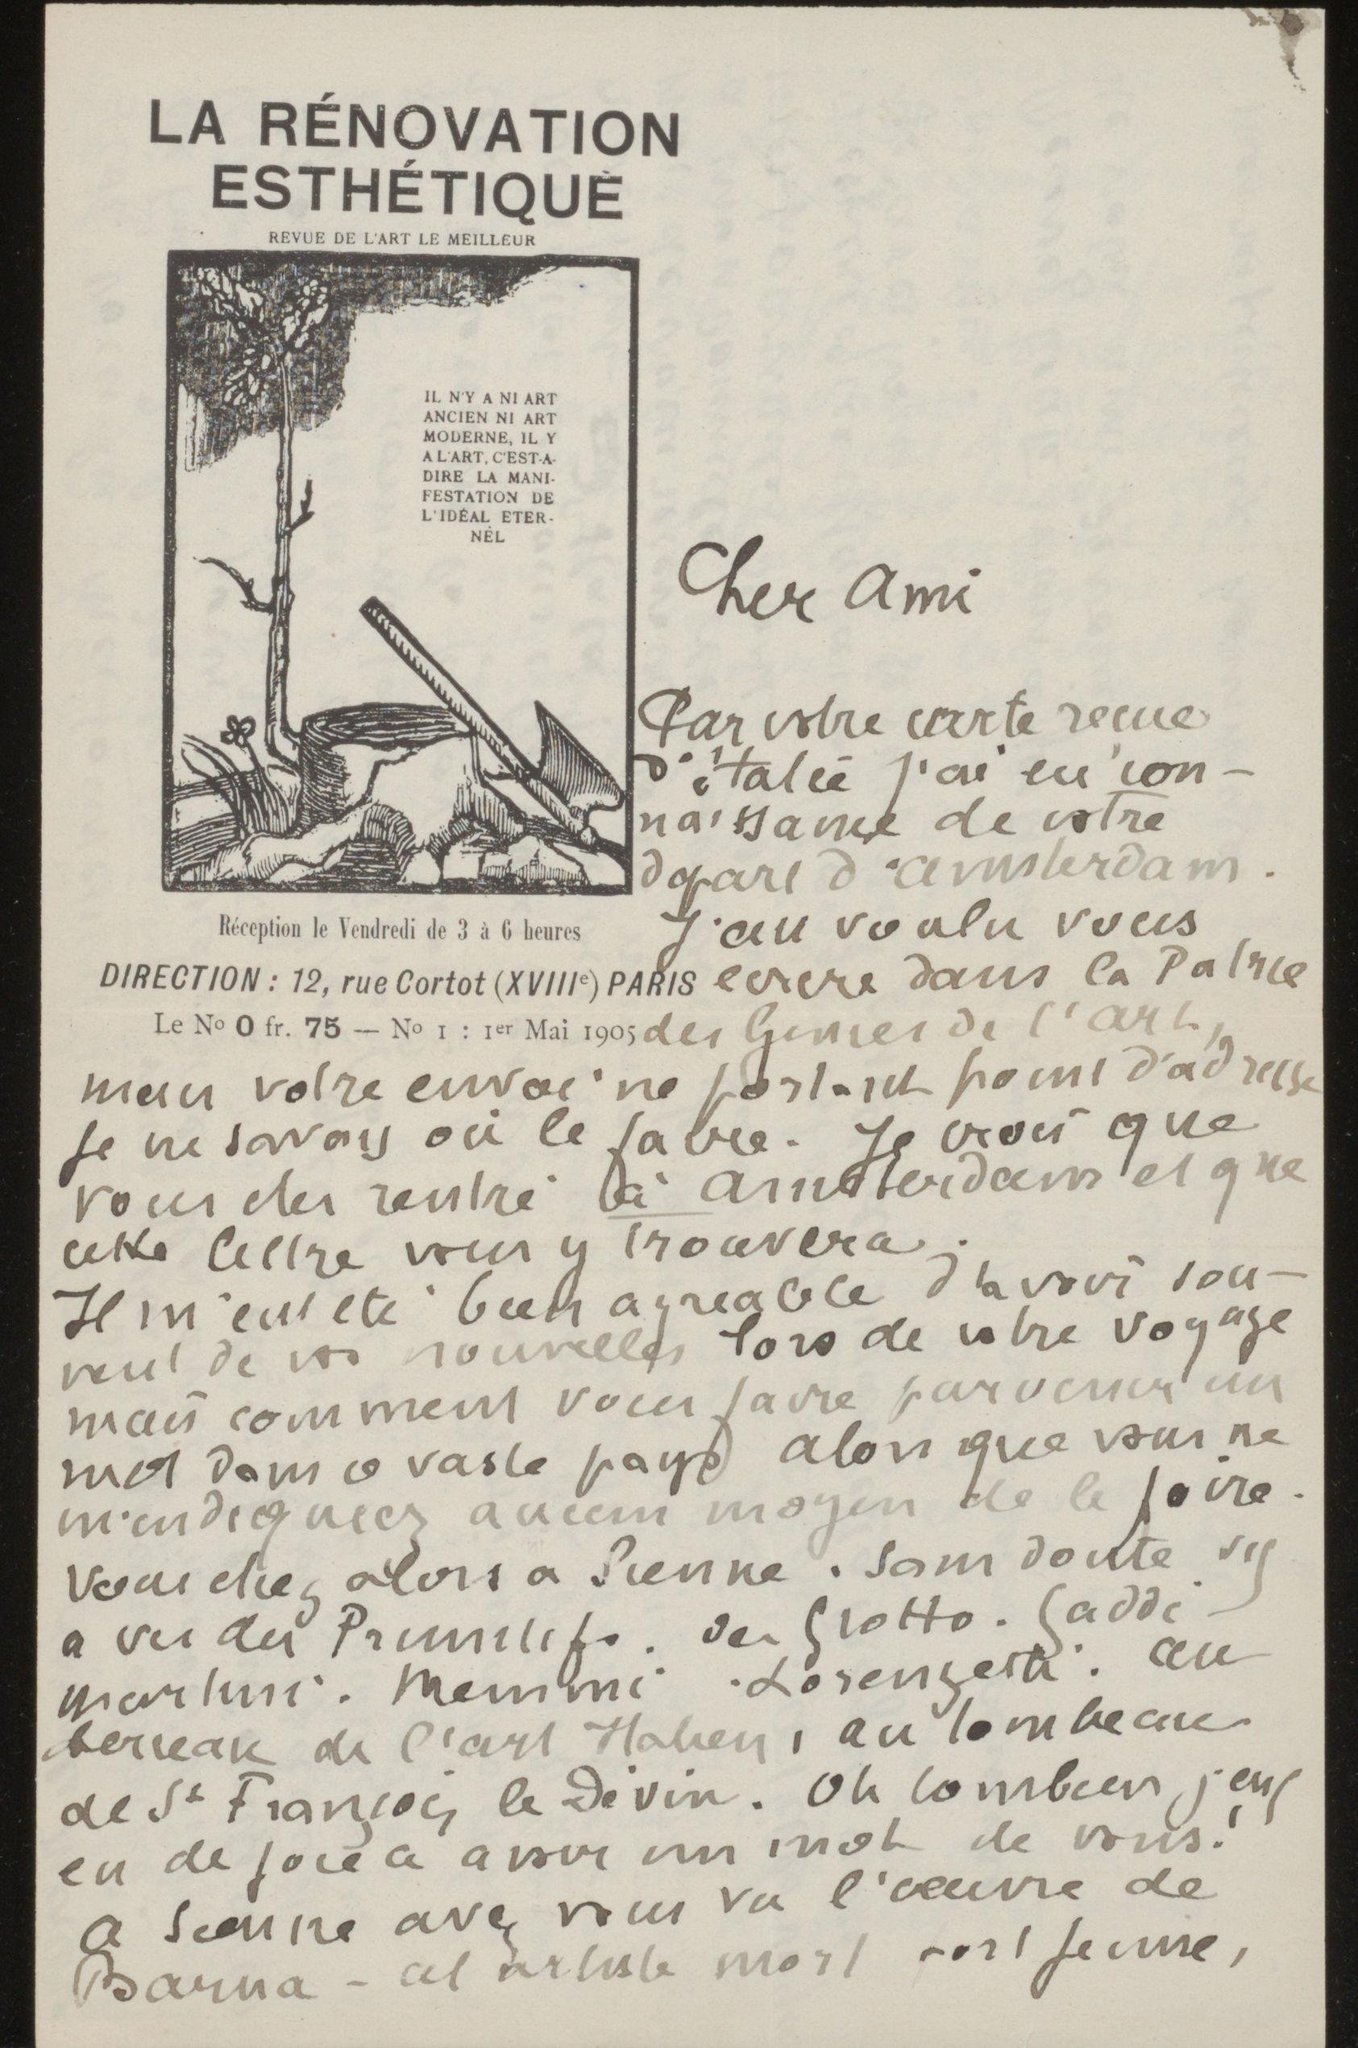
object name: letter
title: Brief aan Andries Bonger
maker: émile bernard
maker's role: print maker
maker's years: 1868-1941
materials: ink, paper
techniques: pen, printing, writing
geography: paris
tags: odilon redon, paul cézanne, agnolo gaddi, giotto de bondone, andries bonger, draughtsman, arnhem, anacapri, sculptor, saar de swart, bartolommeo bulgarini, painter, simone martini, painting (including book-illumination, miniature-painting), workshop, studio of the artist (in general), exhibition ~ art, money, italy, java, prague, paris, amsterdam